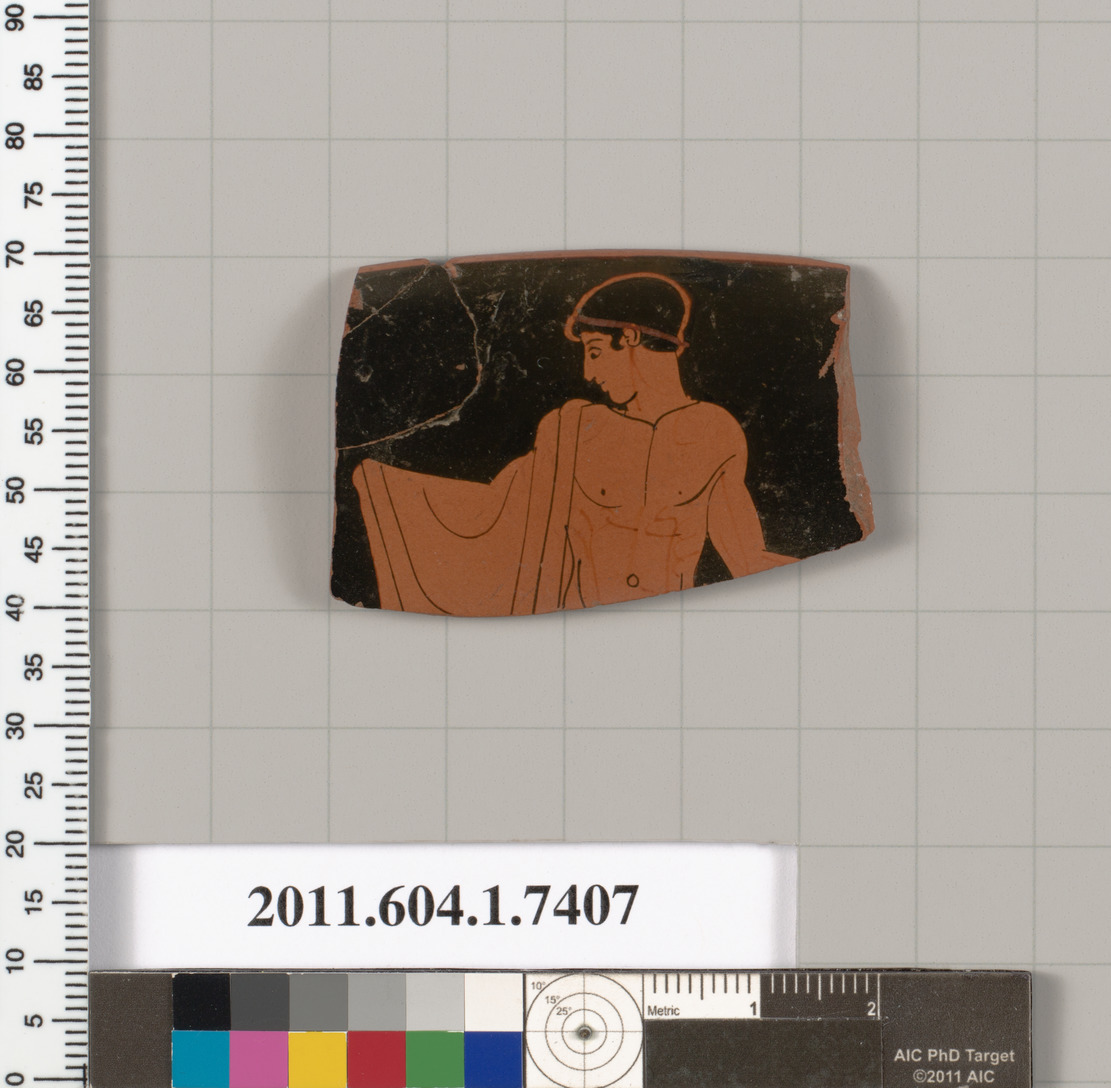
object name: kylix fragment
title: Terracotta rim fragment of a kylix (drinking cup)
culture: greek, attic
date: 490-470 BCE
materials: terracotta